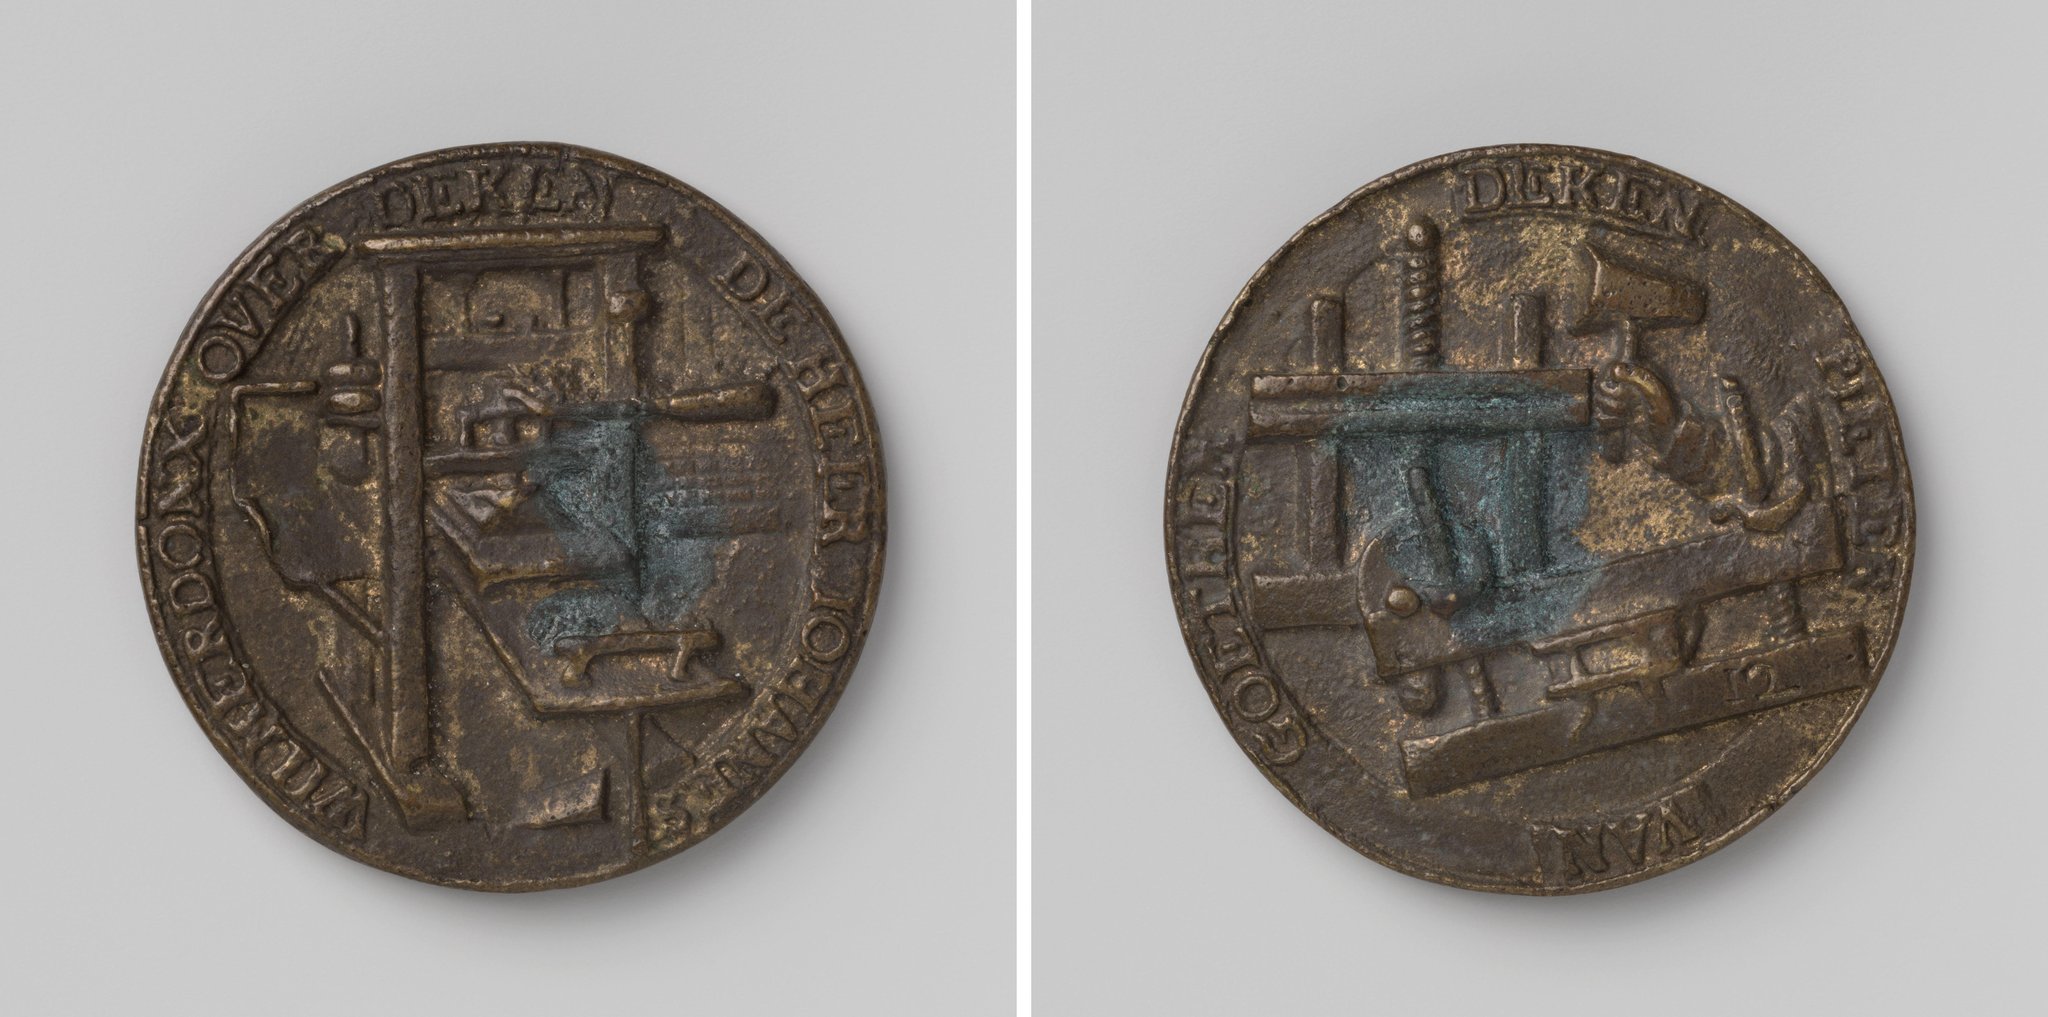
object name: medal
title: Boekdrukkers-, -binders- en -verkopersgilde van Middelburg, gildepenning met no. 12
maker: Anonymous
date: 1662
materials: brass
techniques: casting, engraving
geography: middelburg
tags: middelburg